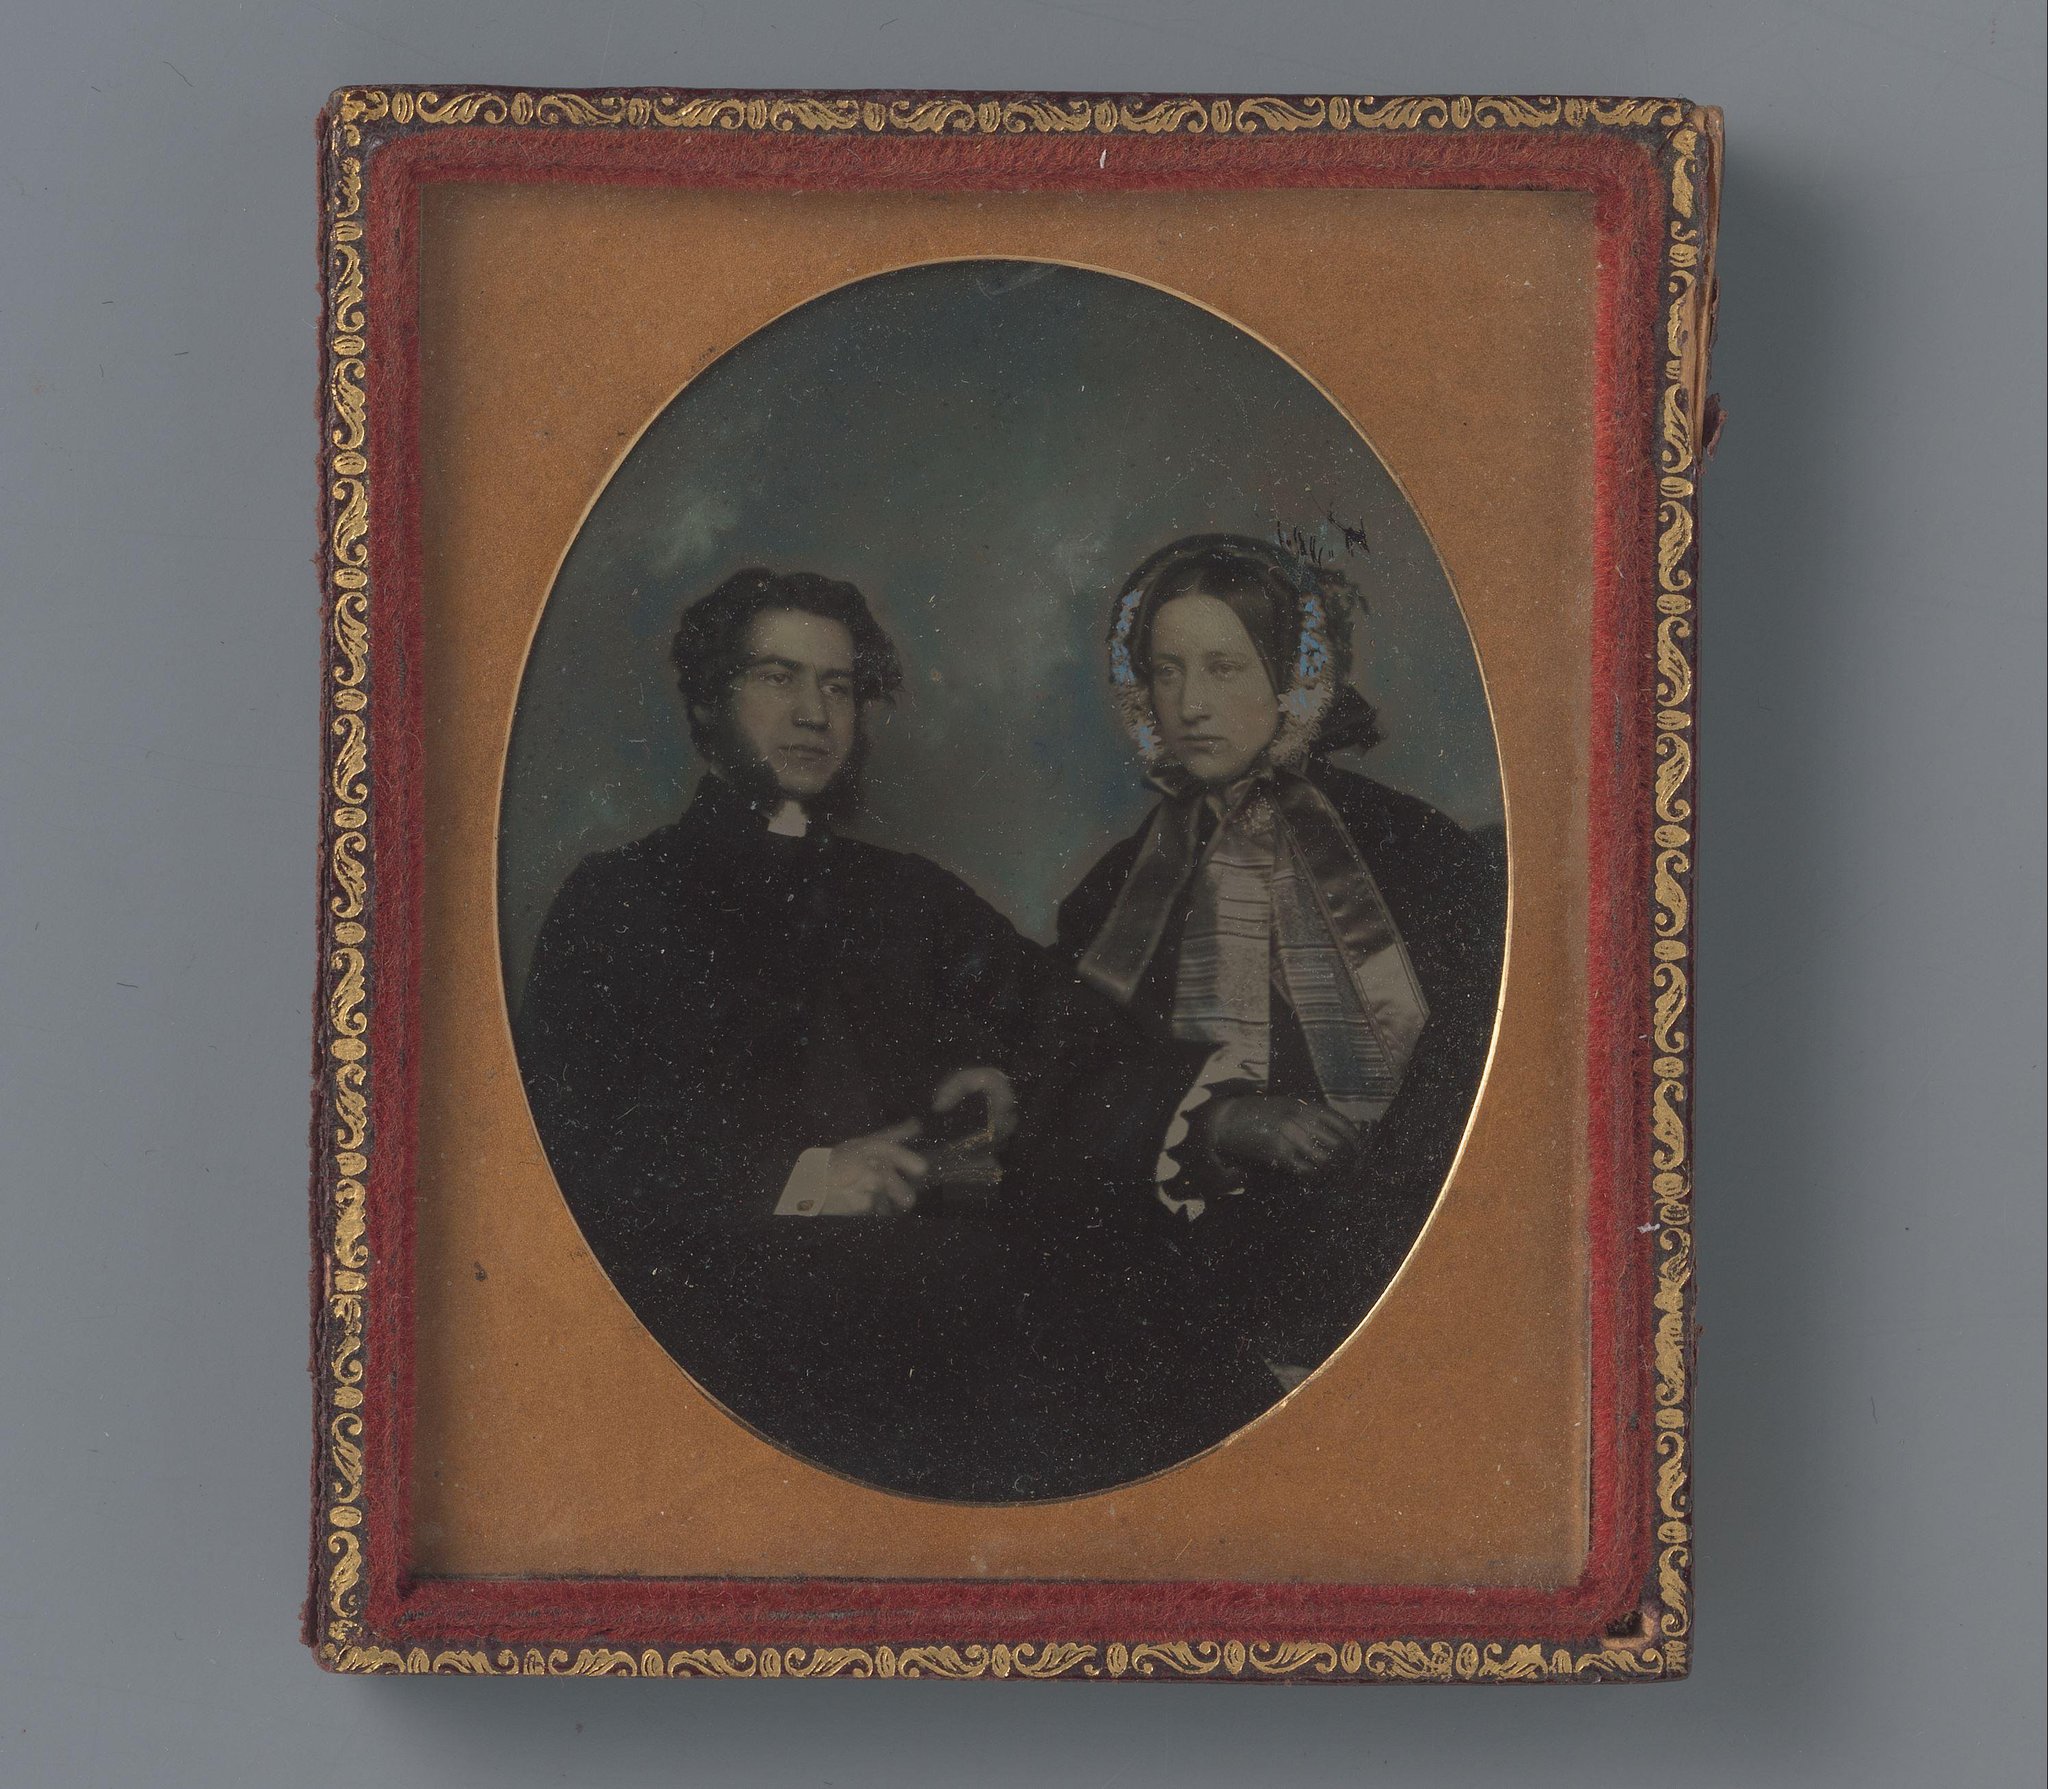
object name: photograph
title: Portret van een onbekend zittend echtpaar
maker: Anonymous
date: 1855-1870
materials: glass, leather, metal, velvet, wood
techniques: ambrotype, hand coloring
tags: historical persons - bb - woman, historical persons, marriage, married couple, 'matrimonium'